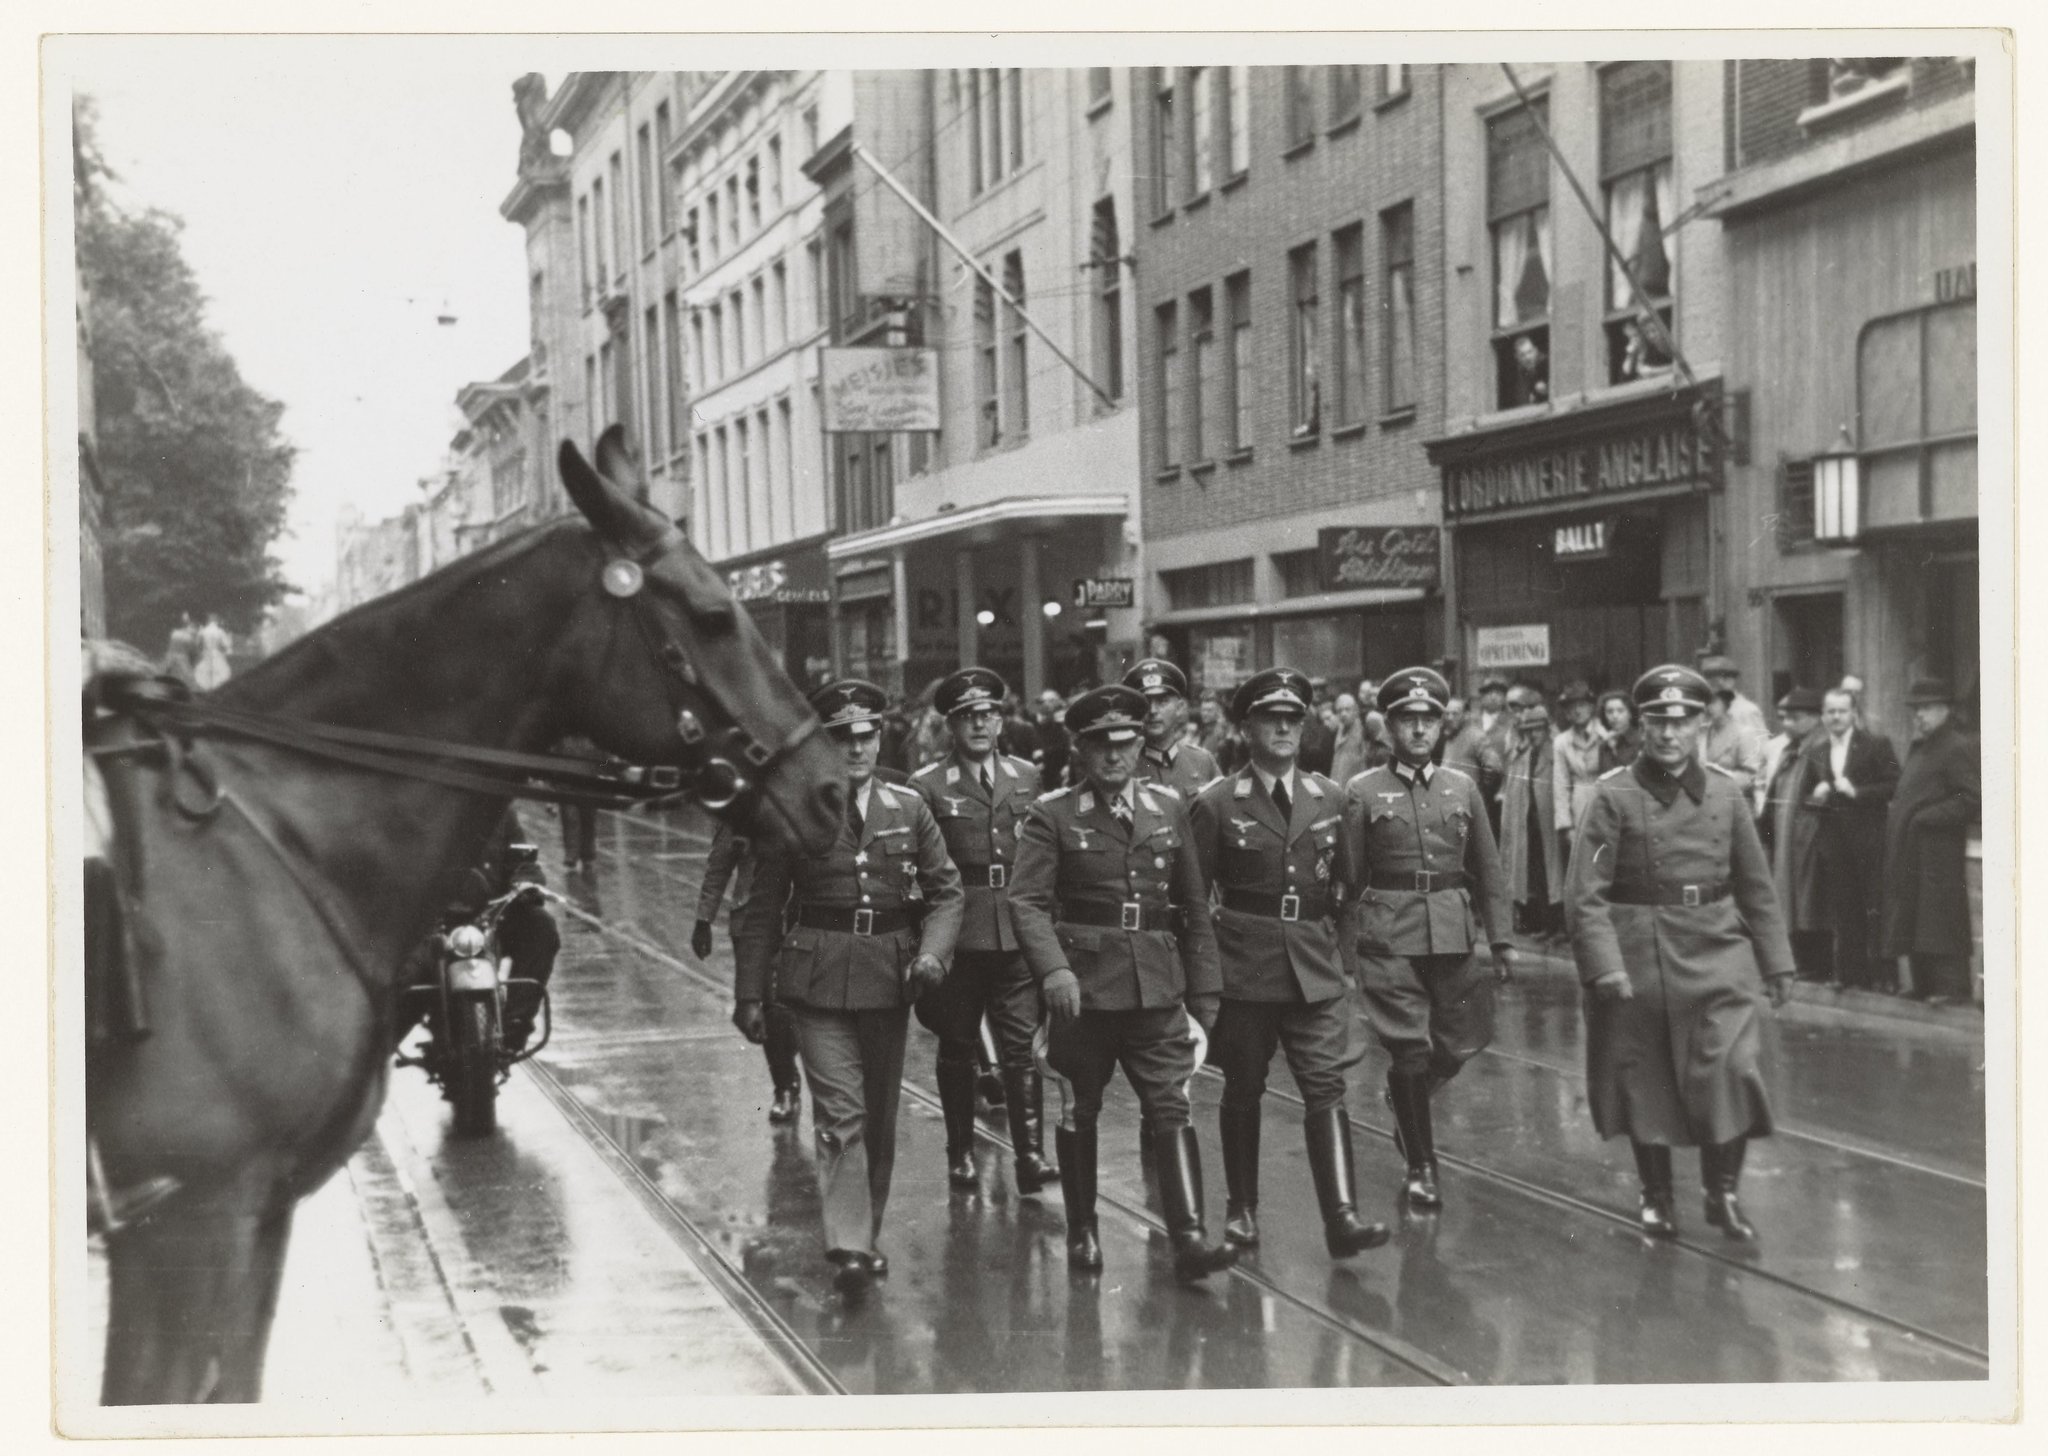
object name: photograph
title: Aankomst Oberbefehlshaber der Wehrmacht F. Christiansen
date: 1940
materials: photographic support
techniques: gelatin silver print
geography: the hague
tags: friedrich christiansen, military parade, pageant, the hague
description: General der Flieger en Oberbefehlshaber der Wehrmacht Friedrich Christiansen (derde van links) arriveert in Den Haag op de Lange Poten in gezelschap van een aantal hoge Duitse officieren. Links het hoofd van een paard. Hij bleef gedurende de oorlog de bevelhebber van de Wehrmacht in Nederland. Hij was ook degene die in 1944 opdracht gaf tot de razzia in Putten.